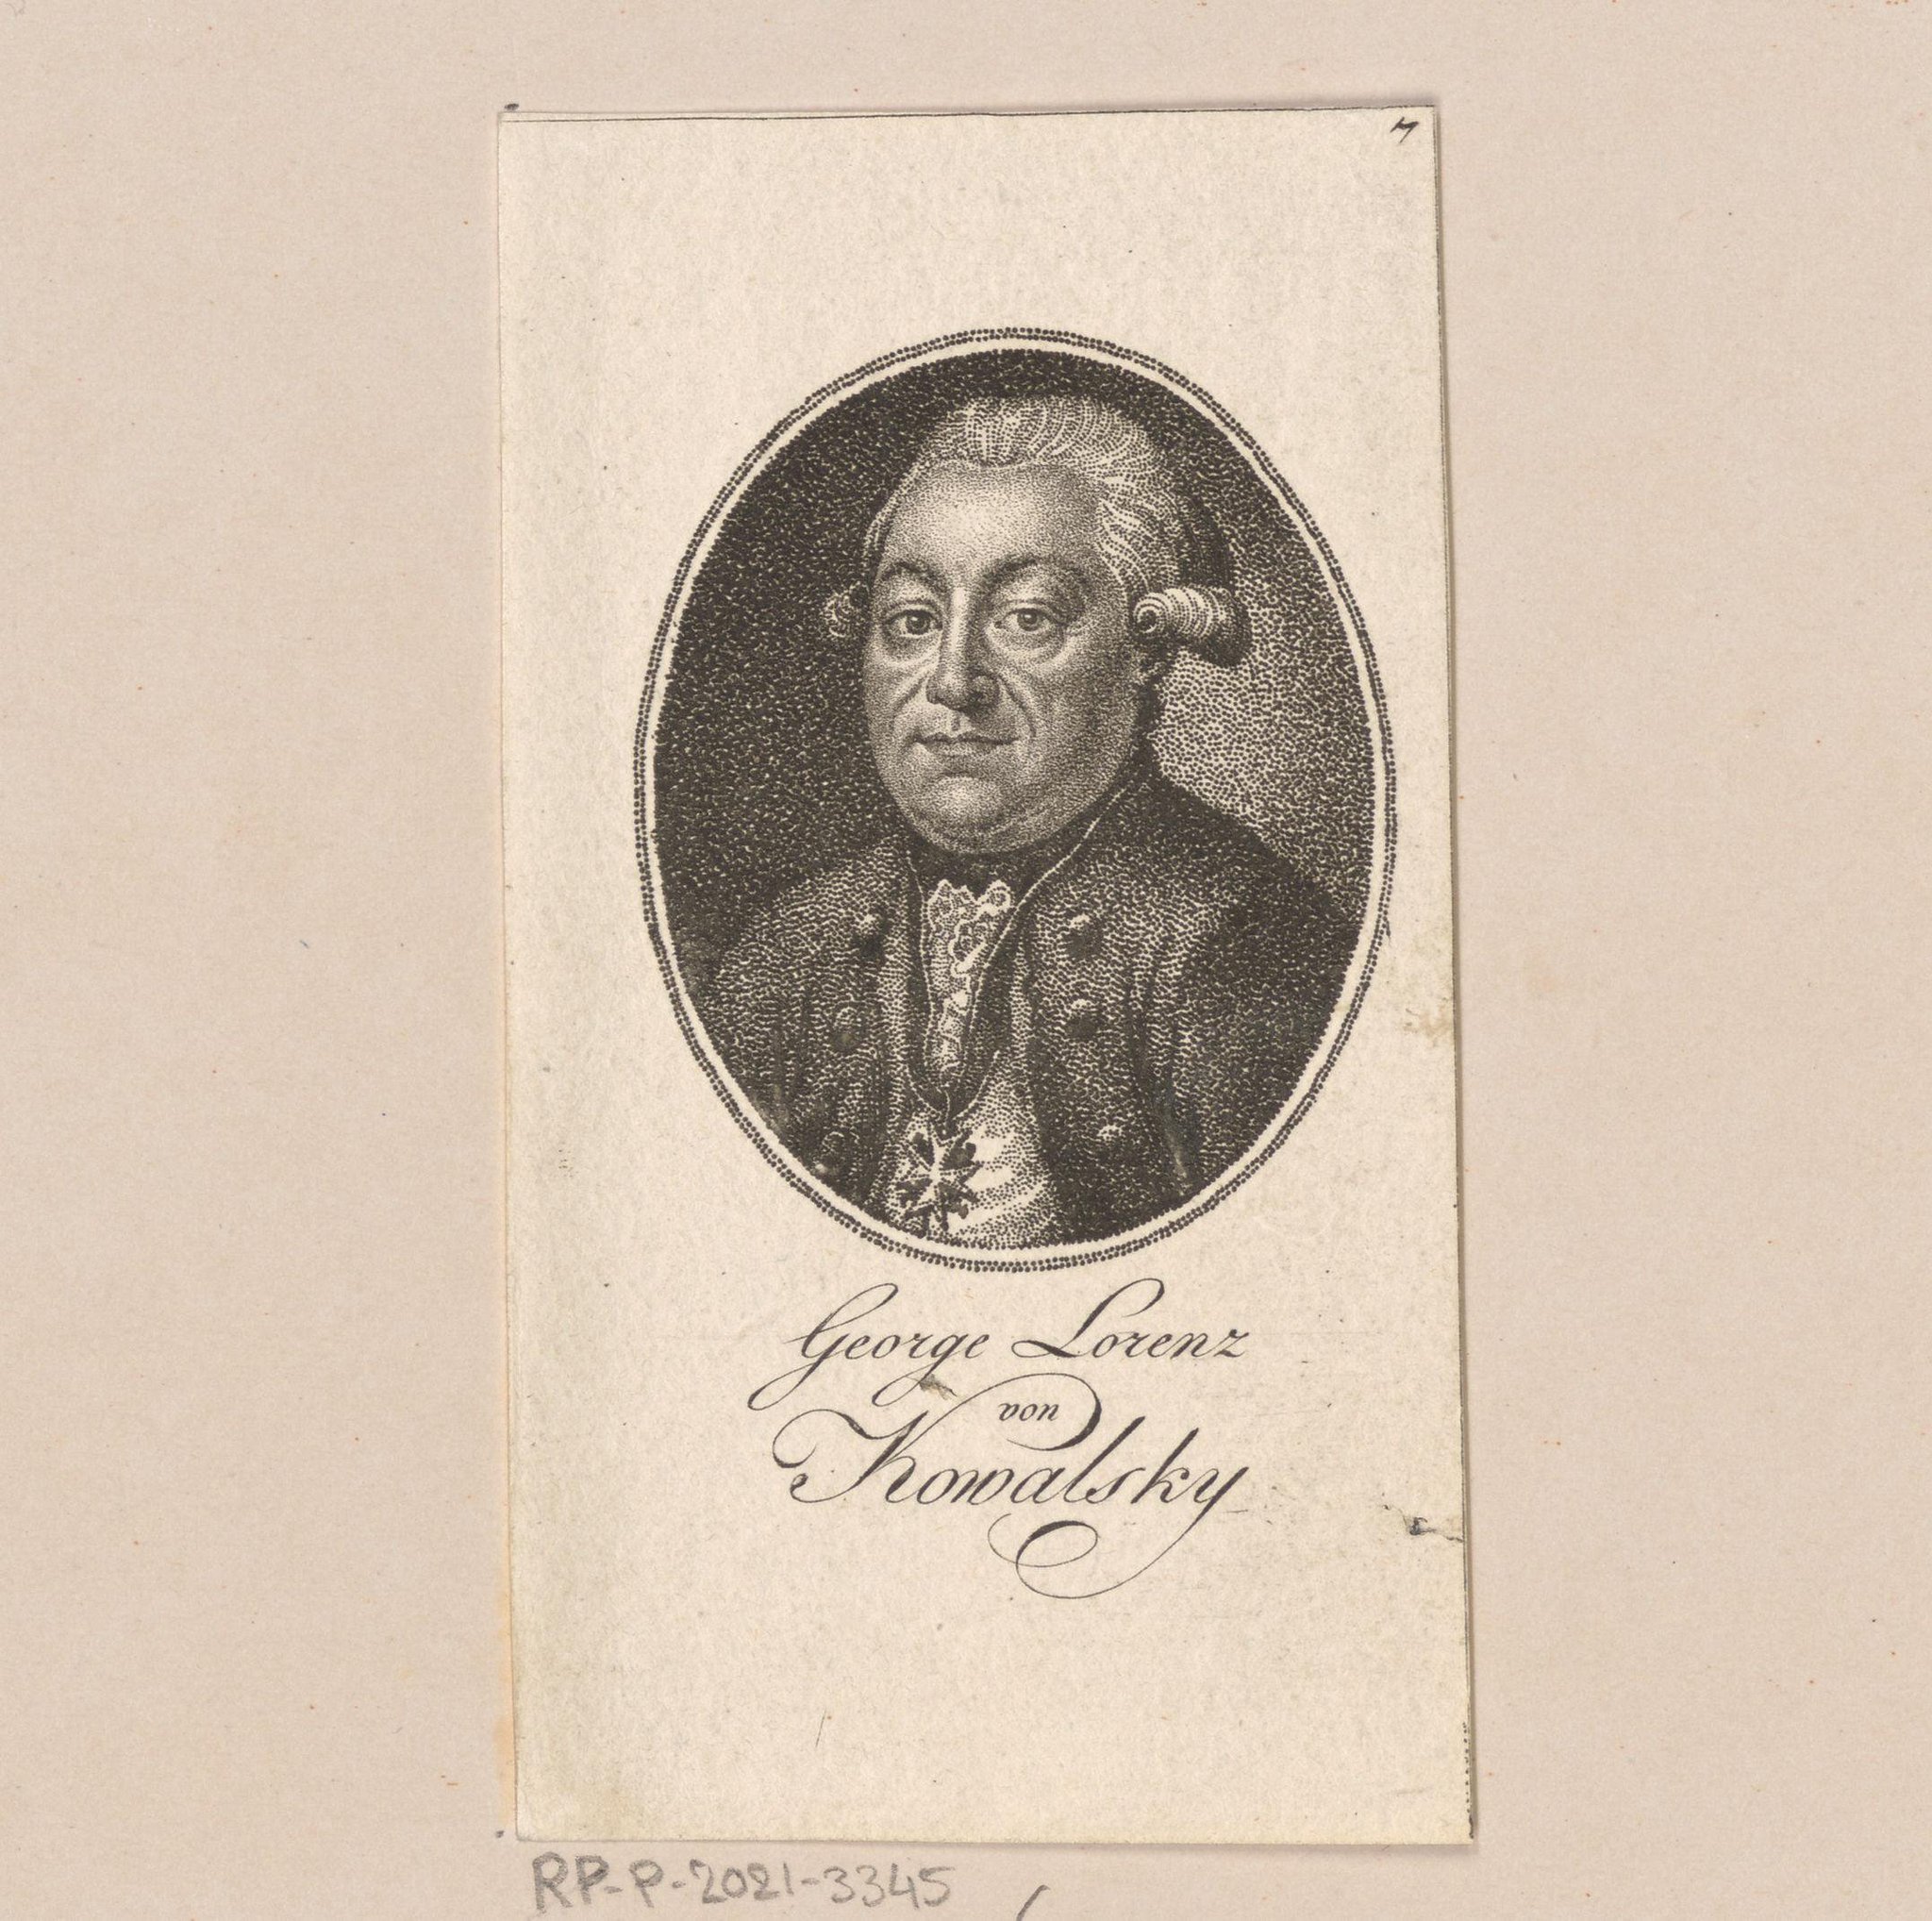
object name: print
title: Portret van George Lorenz von Kowalsky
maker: Anonymous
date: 1747-1799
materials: paper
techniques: engraving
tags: historical persons